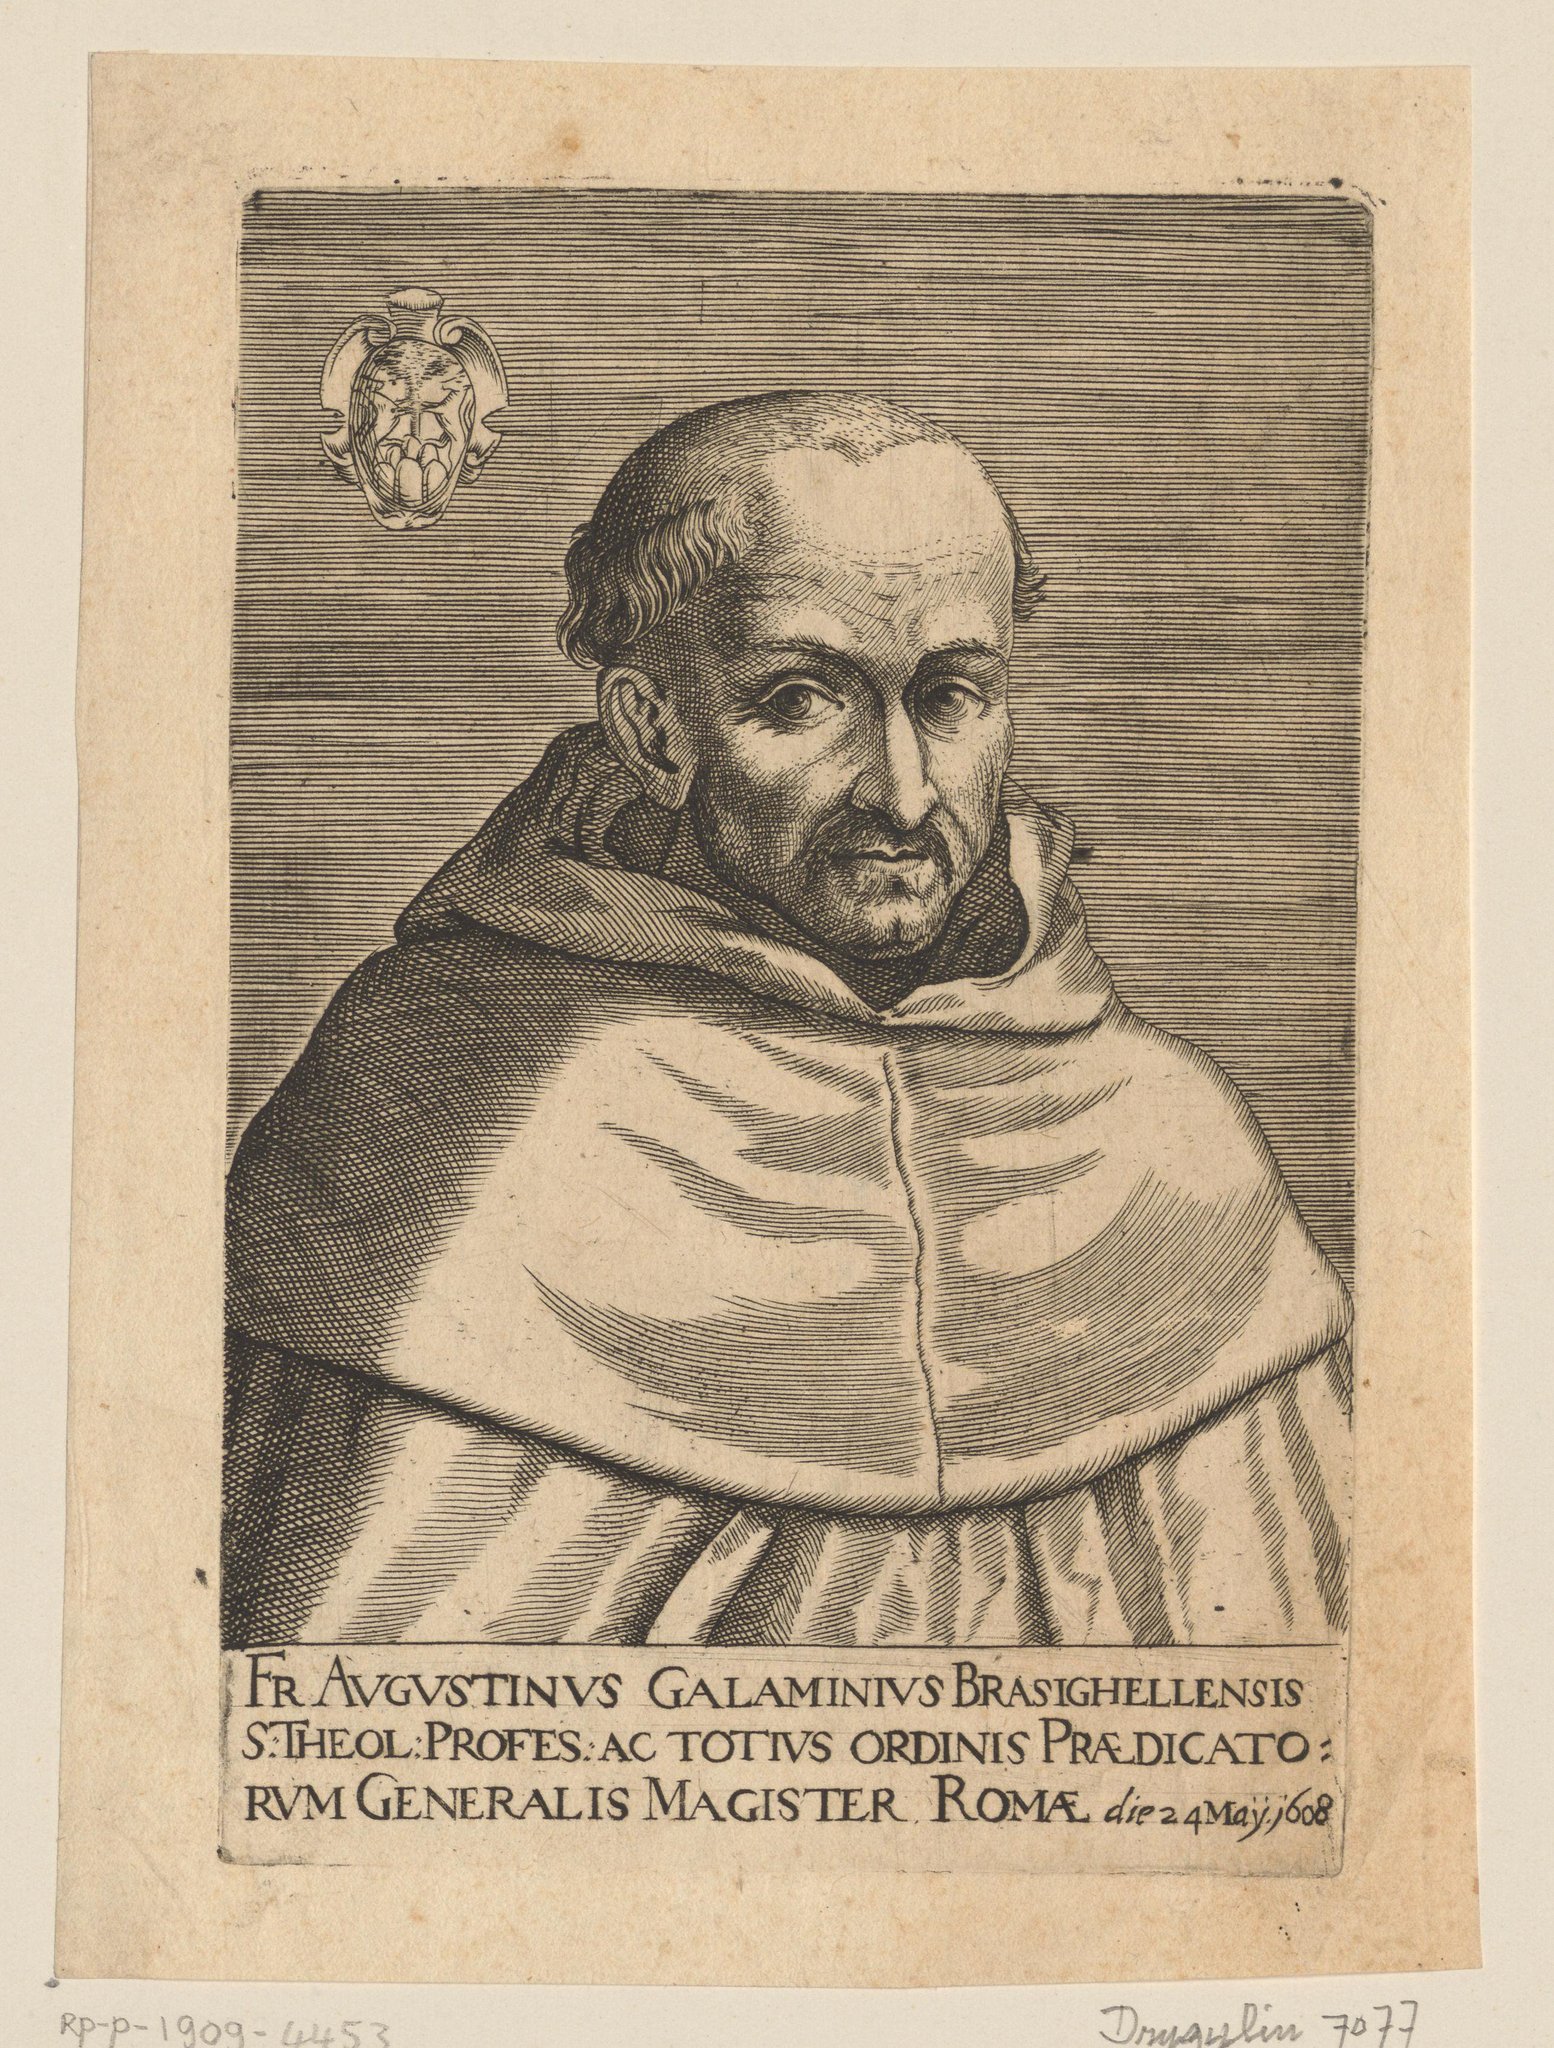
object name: print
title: Portret van Augustino Galaminio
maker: cornelis galle (i)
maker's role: print maker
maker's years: 1576-1650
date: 1608-1650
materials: paper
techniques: engraving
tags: augustino galaminio, theologian, historical persons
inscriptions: collector's mark: Lugt 2228